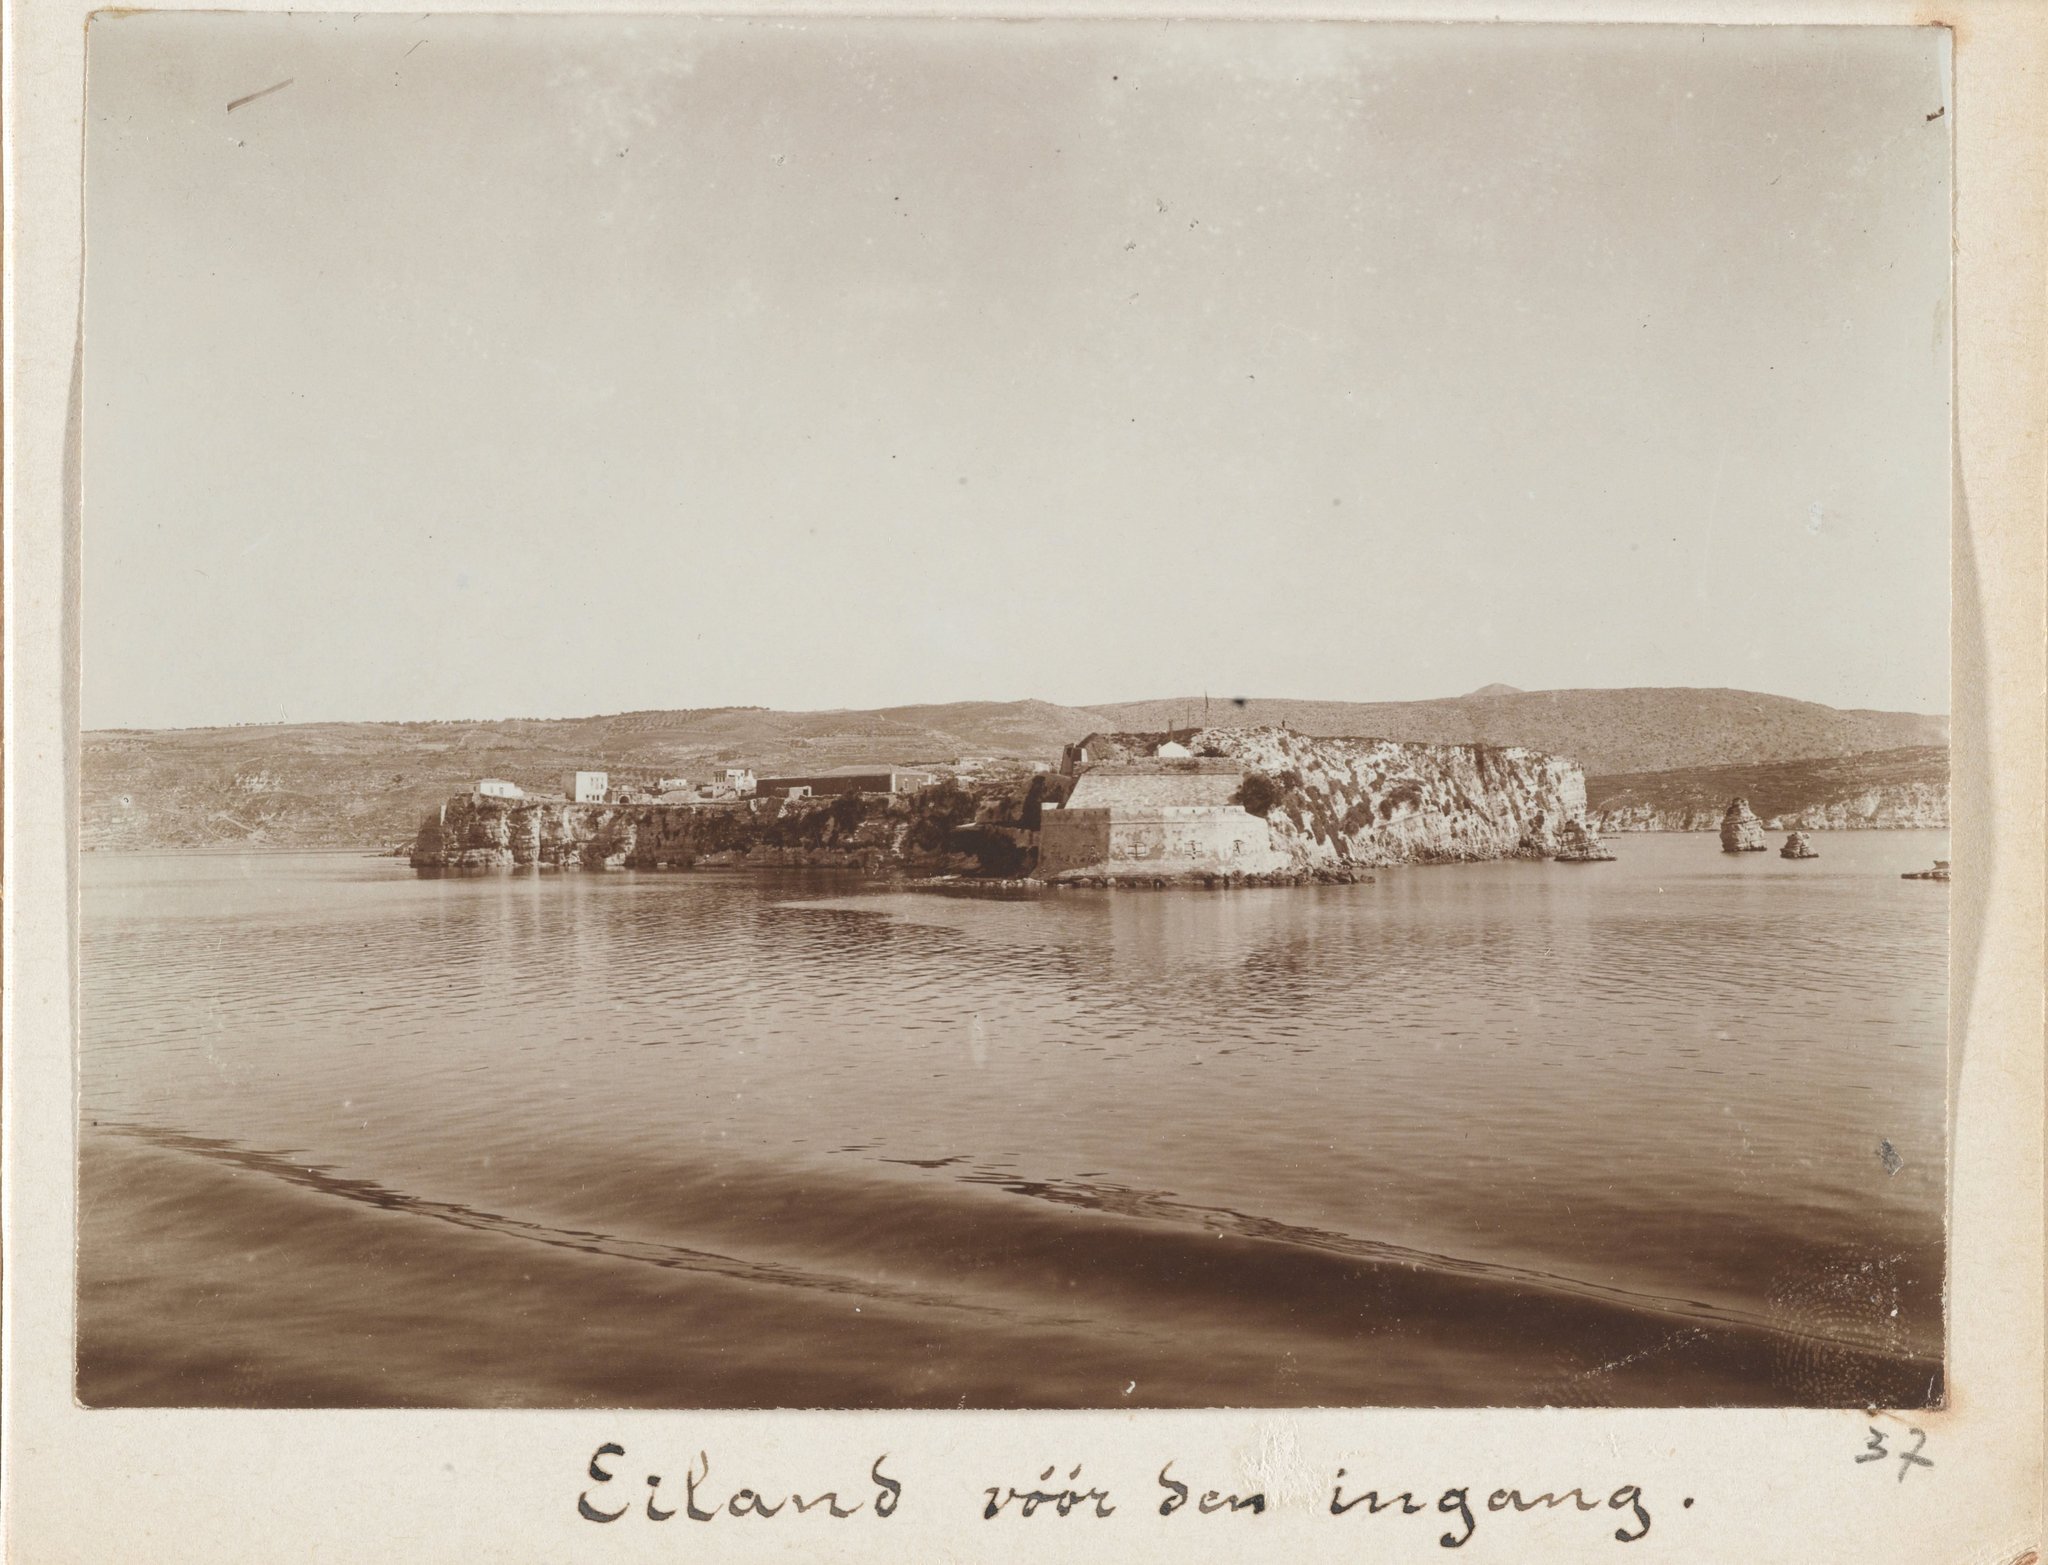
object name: photograph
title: Haven van Suda op Kreta met eiland voor de ingang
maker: johannes lodewijk heldring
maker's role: fotograaf, predikant, schrijver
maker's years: 1852-1923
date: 1898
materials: paper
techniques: collodion silver print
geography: creta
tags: island